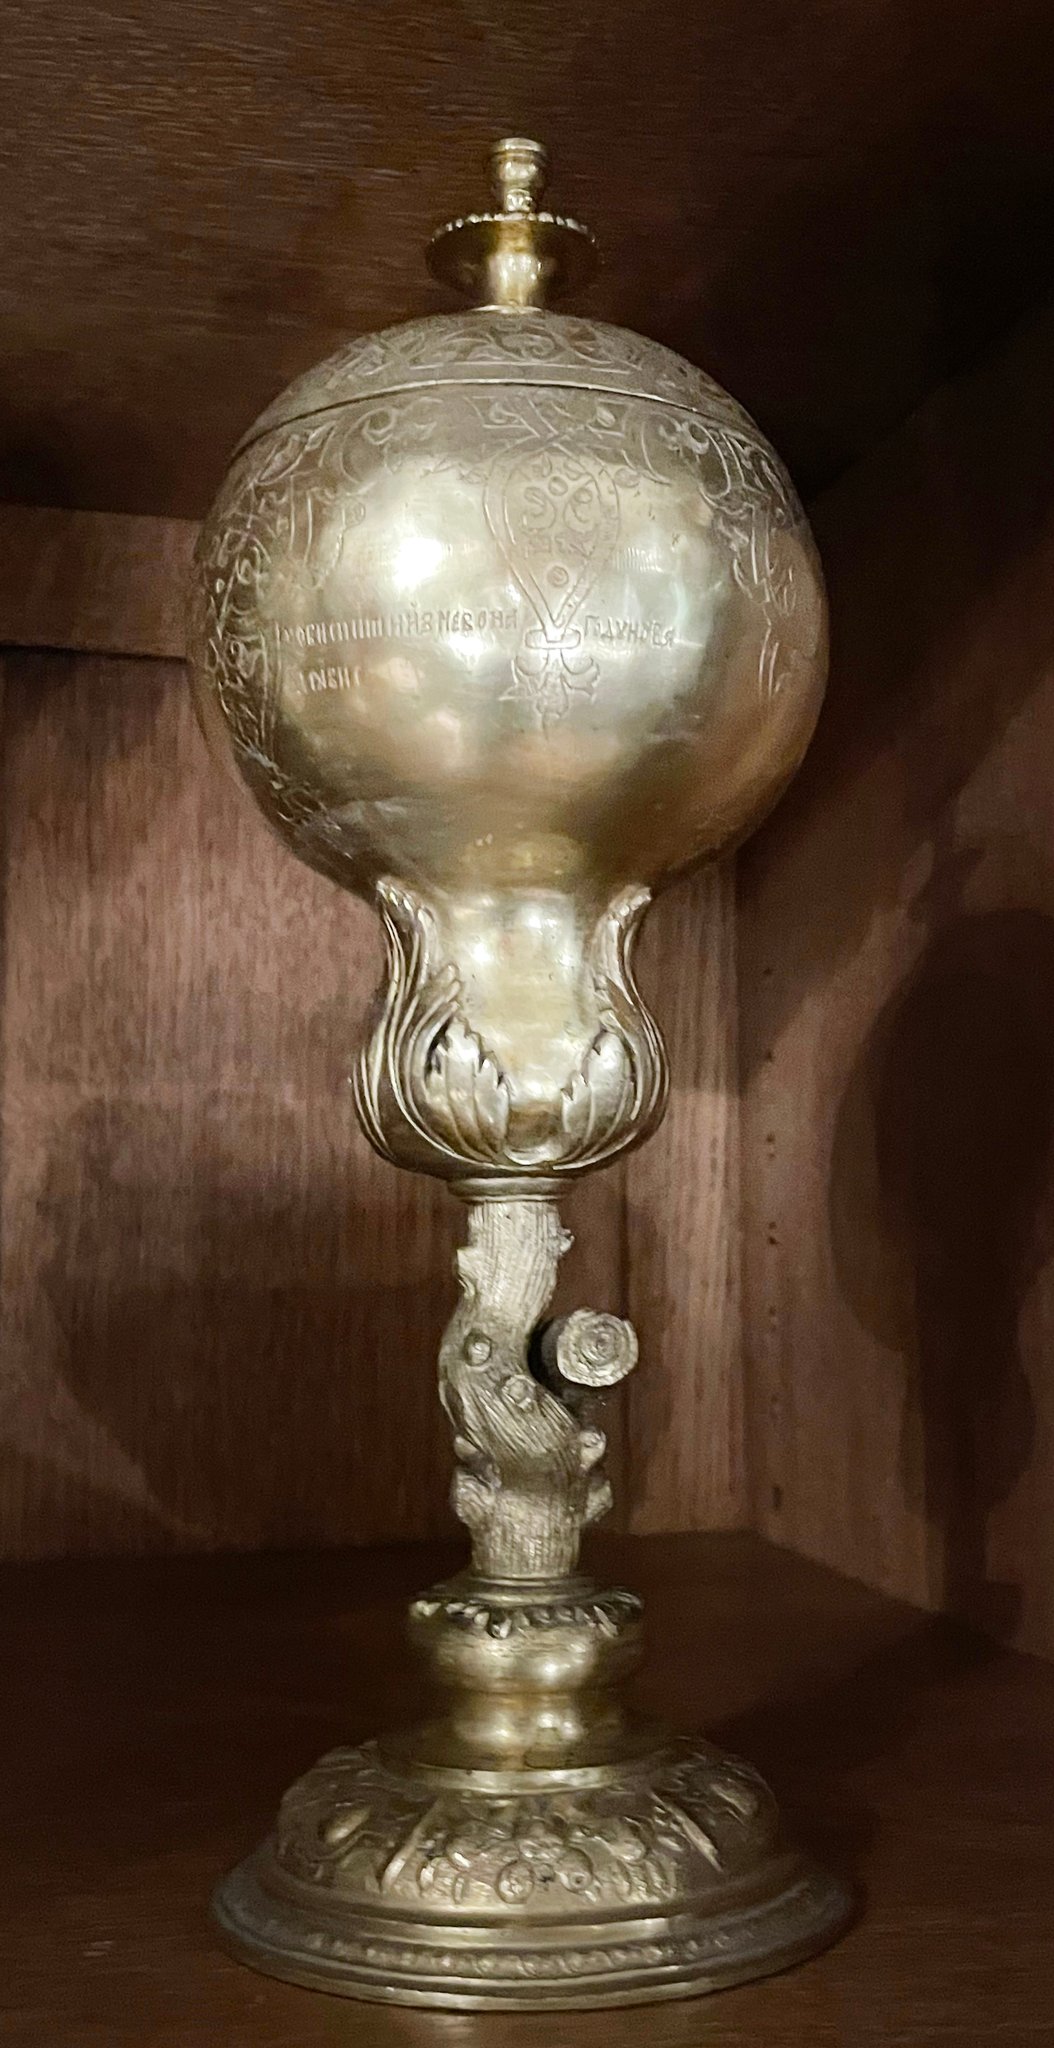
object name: cup with cover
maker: elkington & co.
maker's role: manufacturer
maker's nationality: british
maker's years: 1829-1963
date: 1801-1900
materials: metal, silver